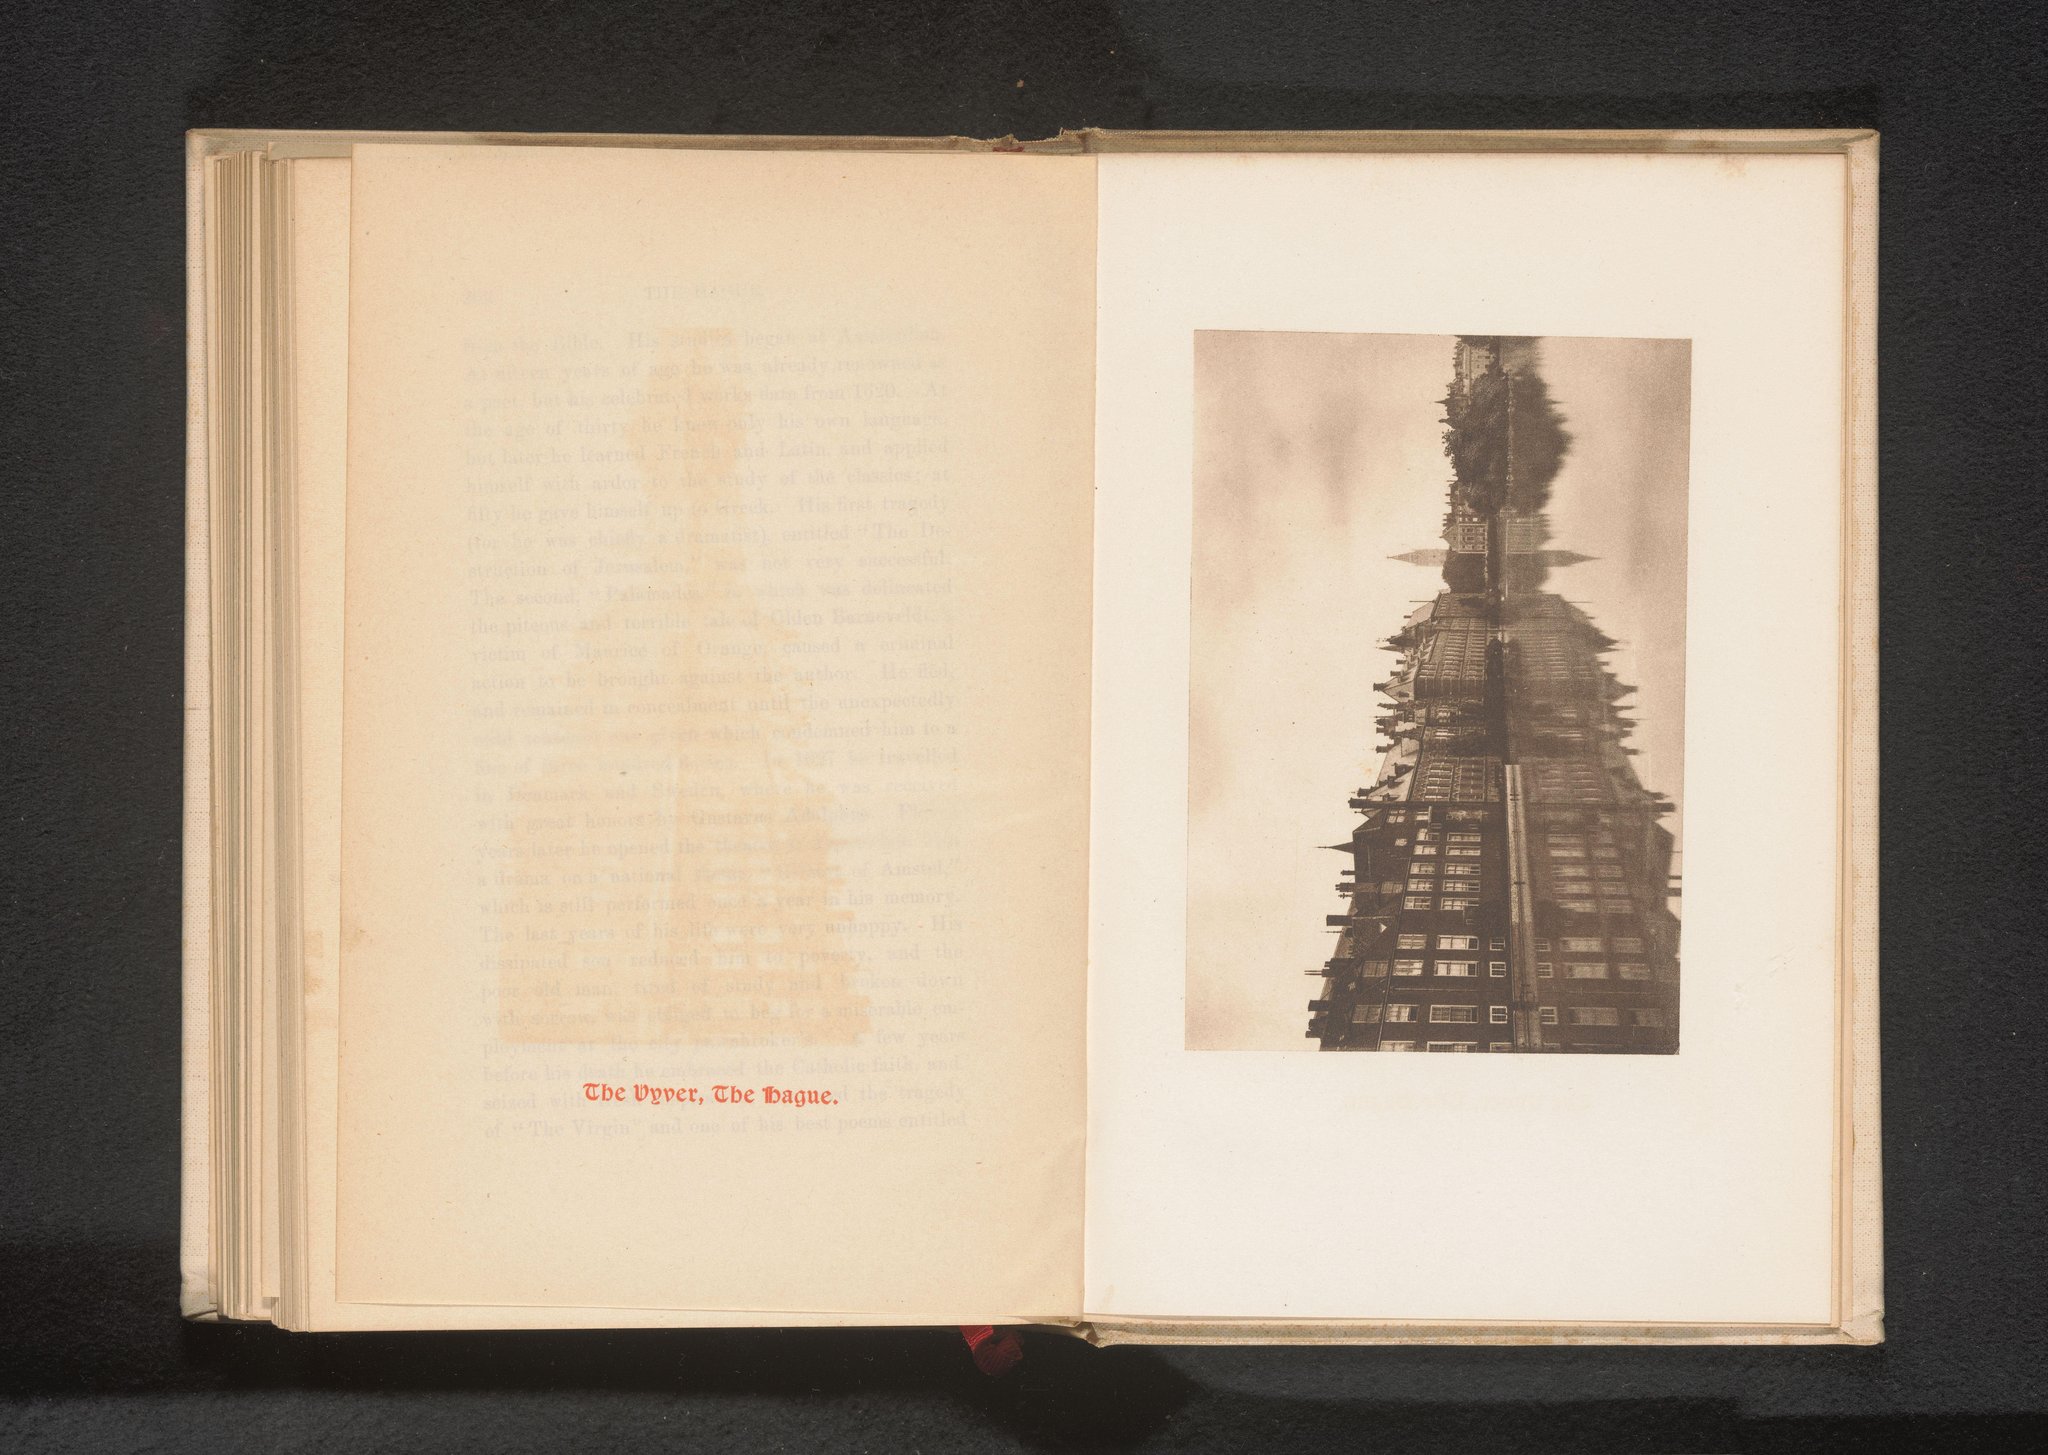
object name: page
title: Gezicht op de Hofvijver te Den Haag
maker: charles l. mitchell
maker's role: fotograaf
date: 1884-1894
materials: paper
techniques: photoaquatint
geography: the hague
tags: pond, pool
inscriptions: title: ‘The Vyver, The Hague.’